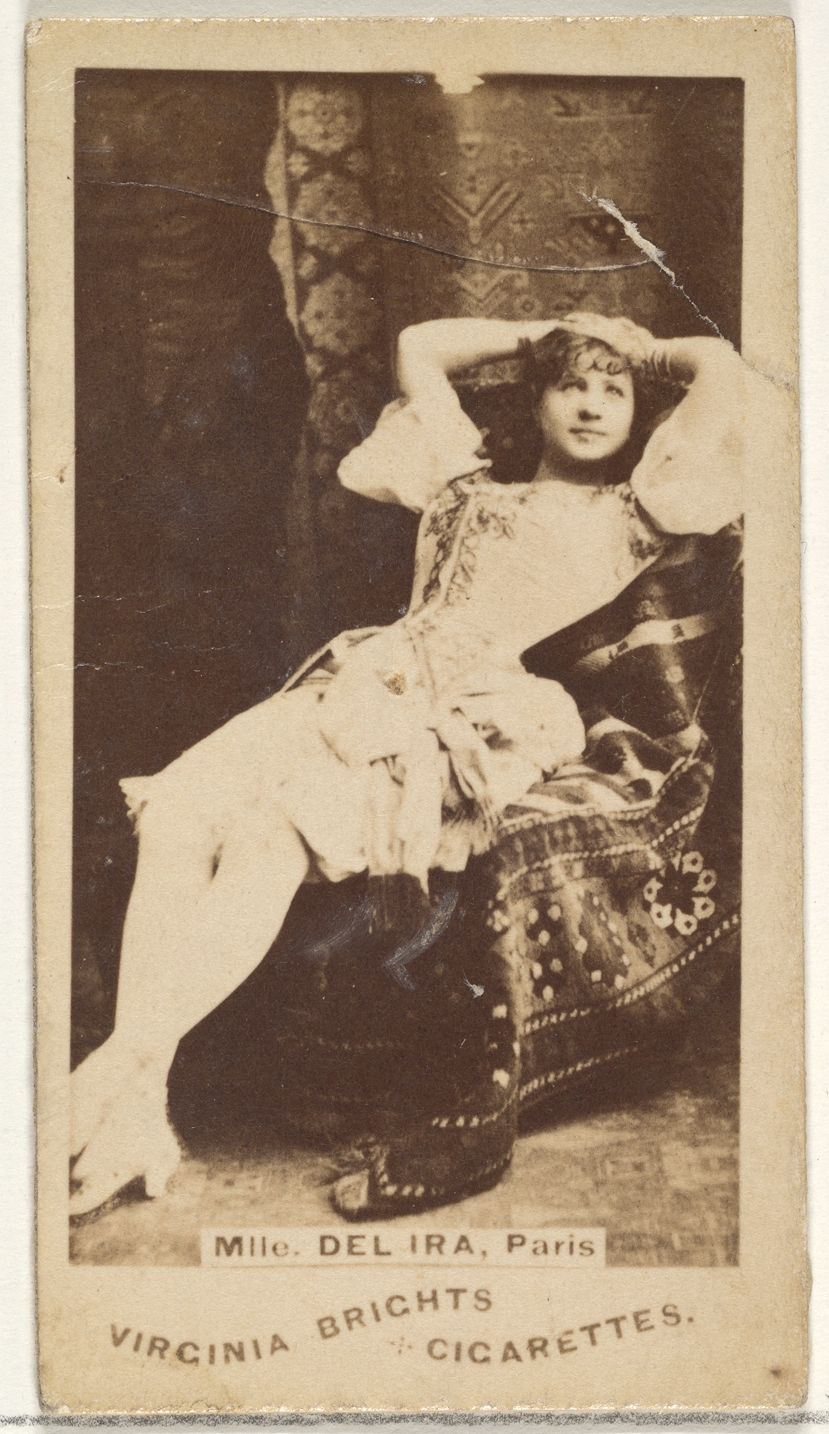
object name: photograph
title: Mlle. Del Ira, Paris, from the Actors and Actresses series (N45, Type 1) for Virginia Brights Cigarettes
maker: allen & ginter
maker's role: publisher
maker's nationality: american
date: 1888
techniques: albumen silver print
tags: portraits,women,actresses